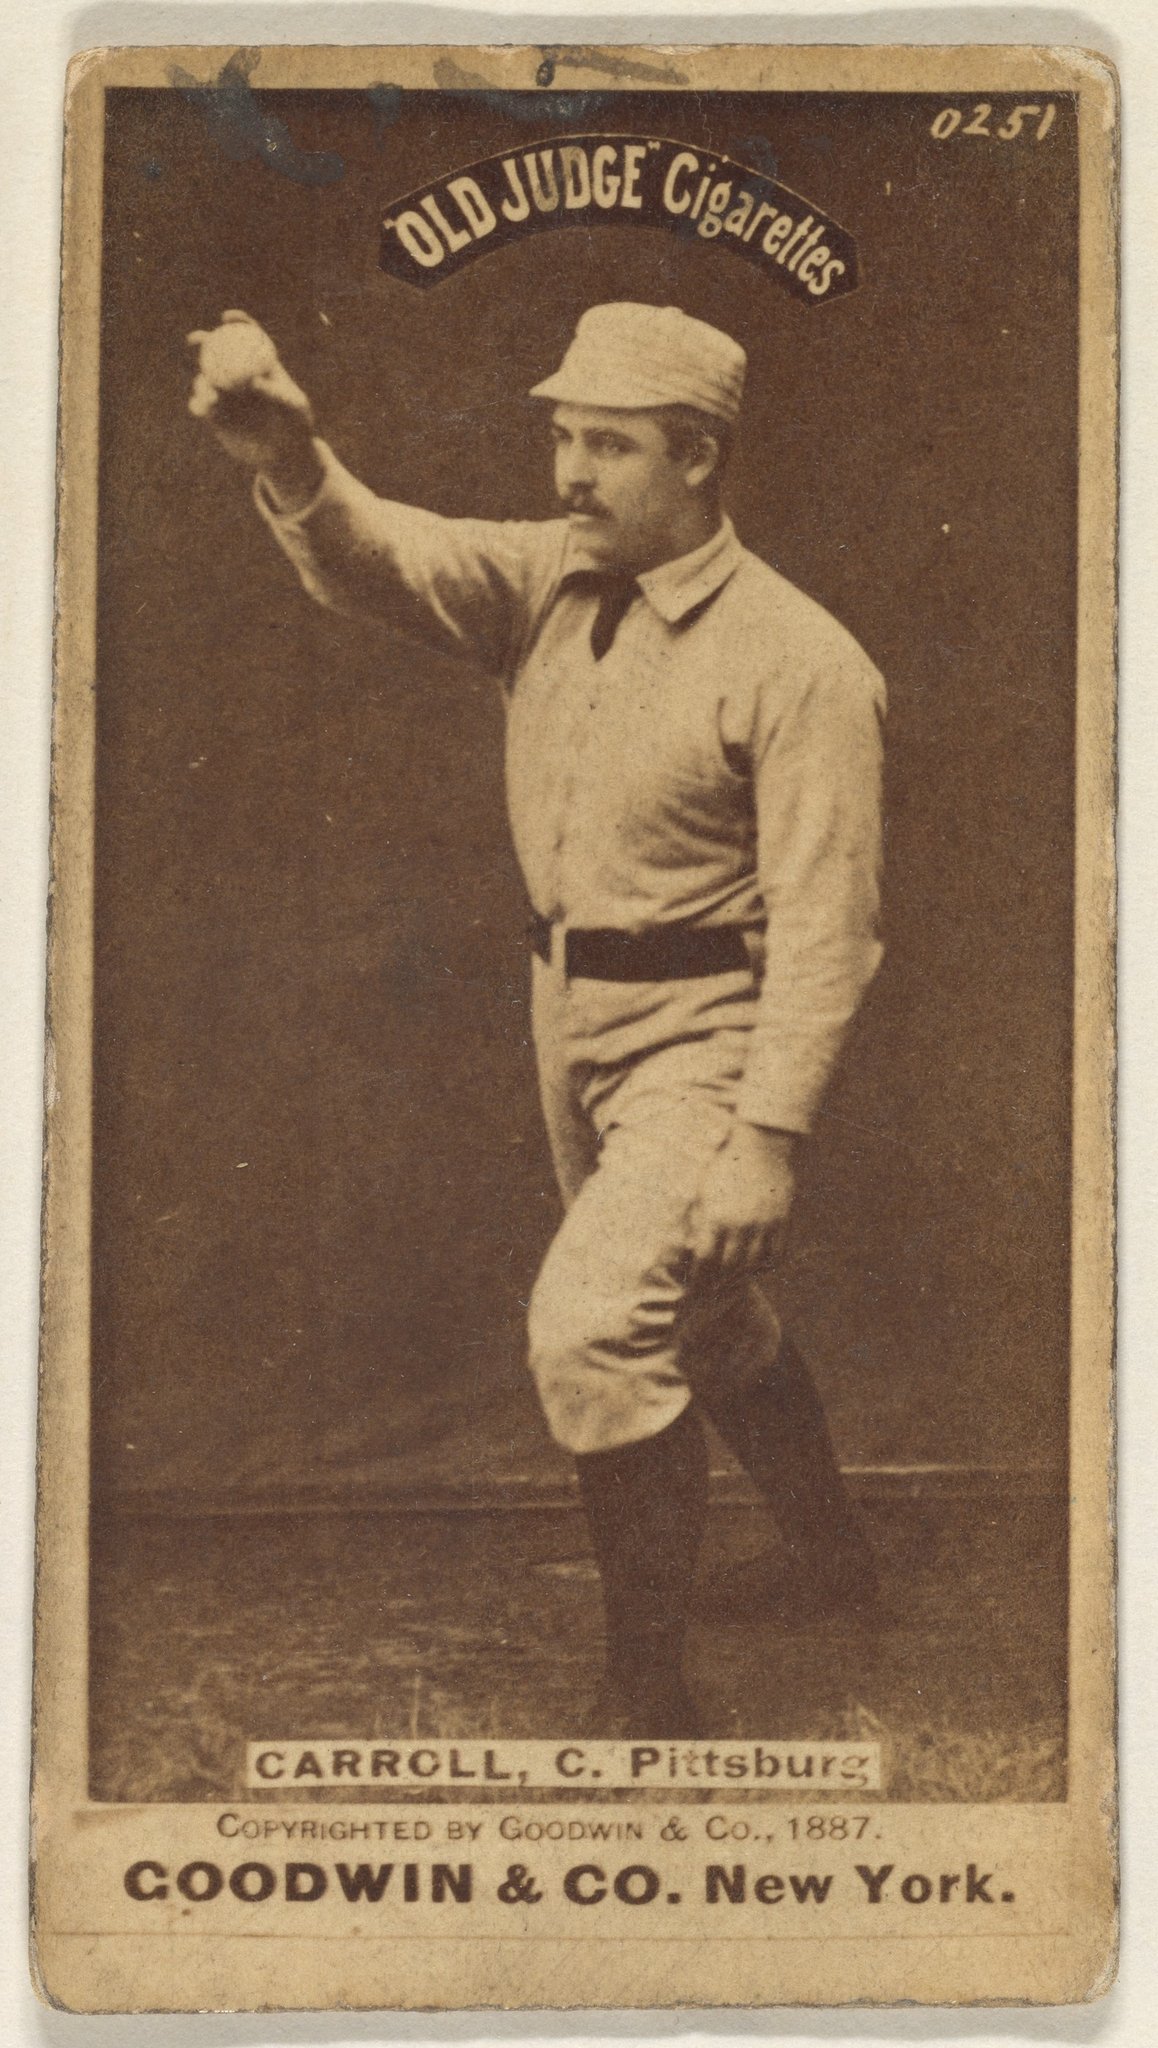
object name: baseball card, photograph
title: Frederick Herbert "Fred" Carroll, Catcher, Pittsburgh, from the Old Judge series (N172) for Old Judge Cigarettes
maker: goodwin & company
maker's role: publisher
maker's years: 1850-1950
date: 1887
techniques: albumen silver print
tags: men,portraits,baseball,athletes